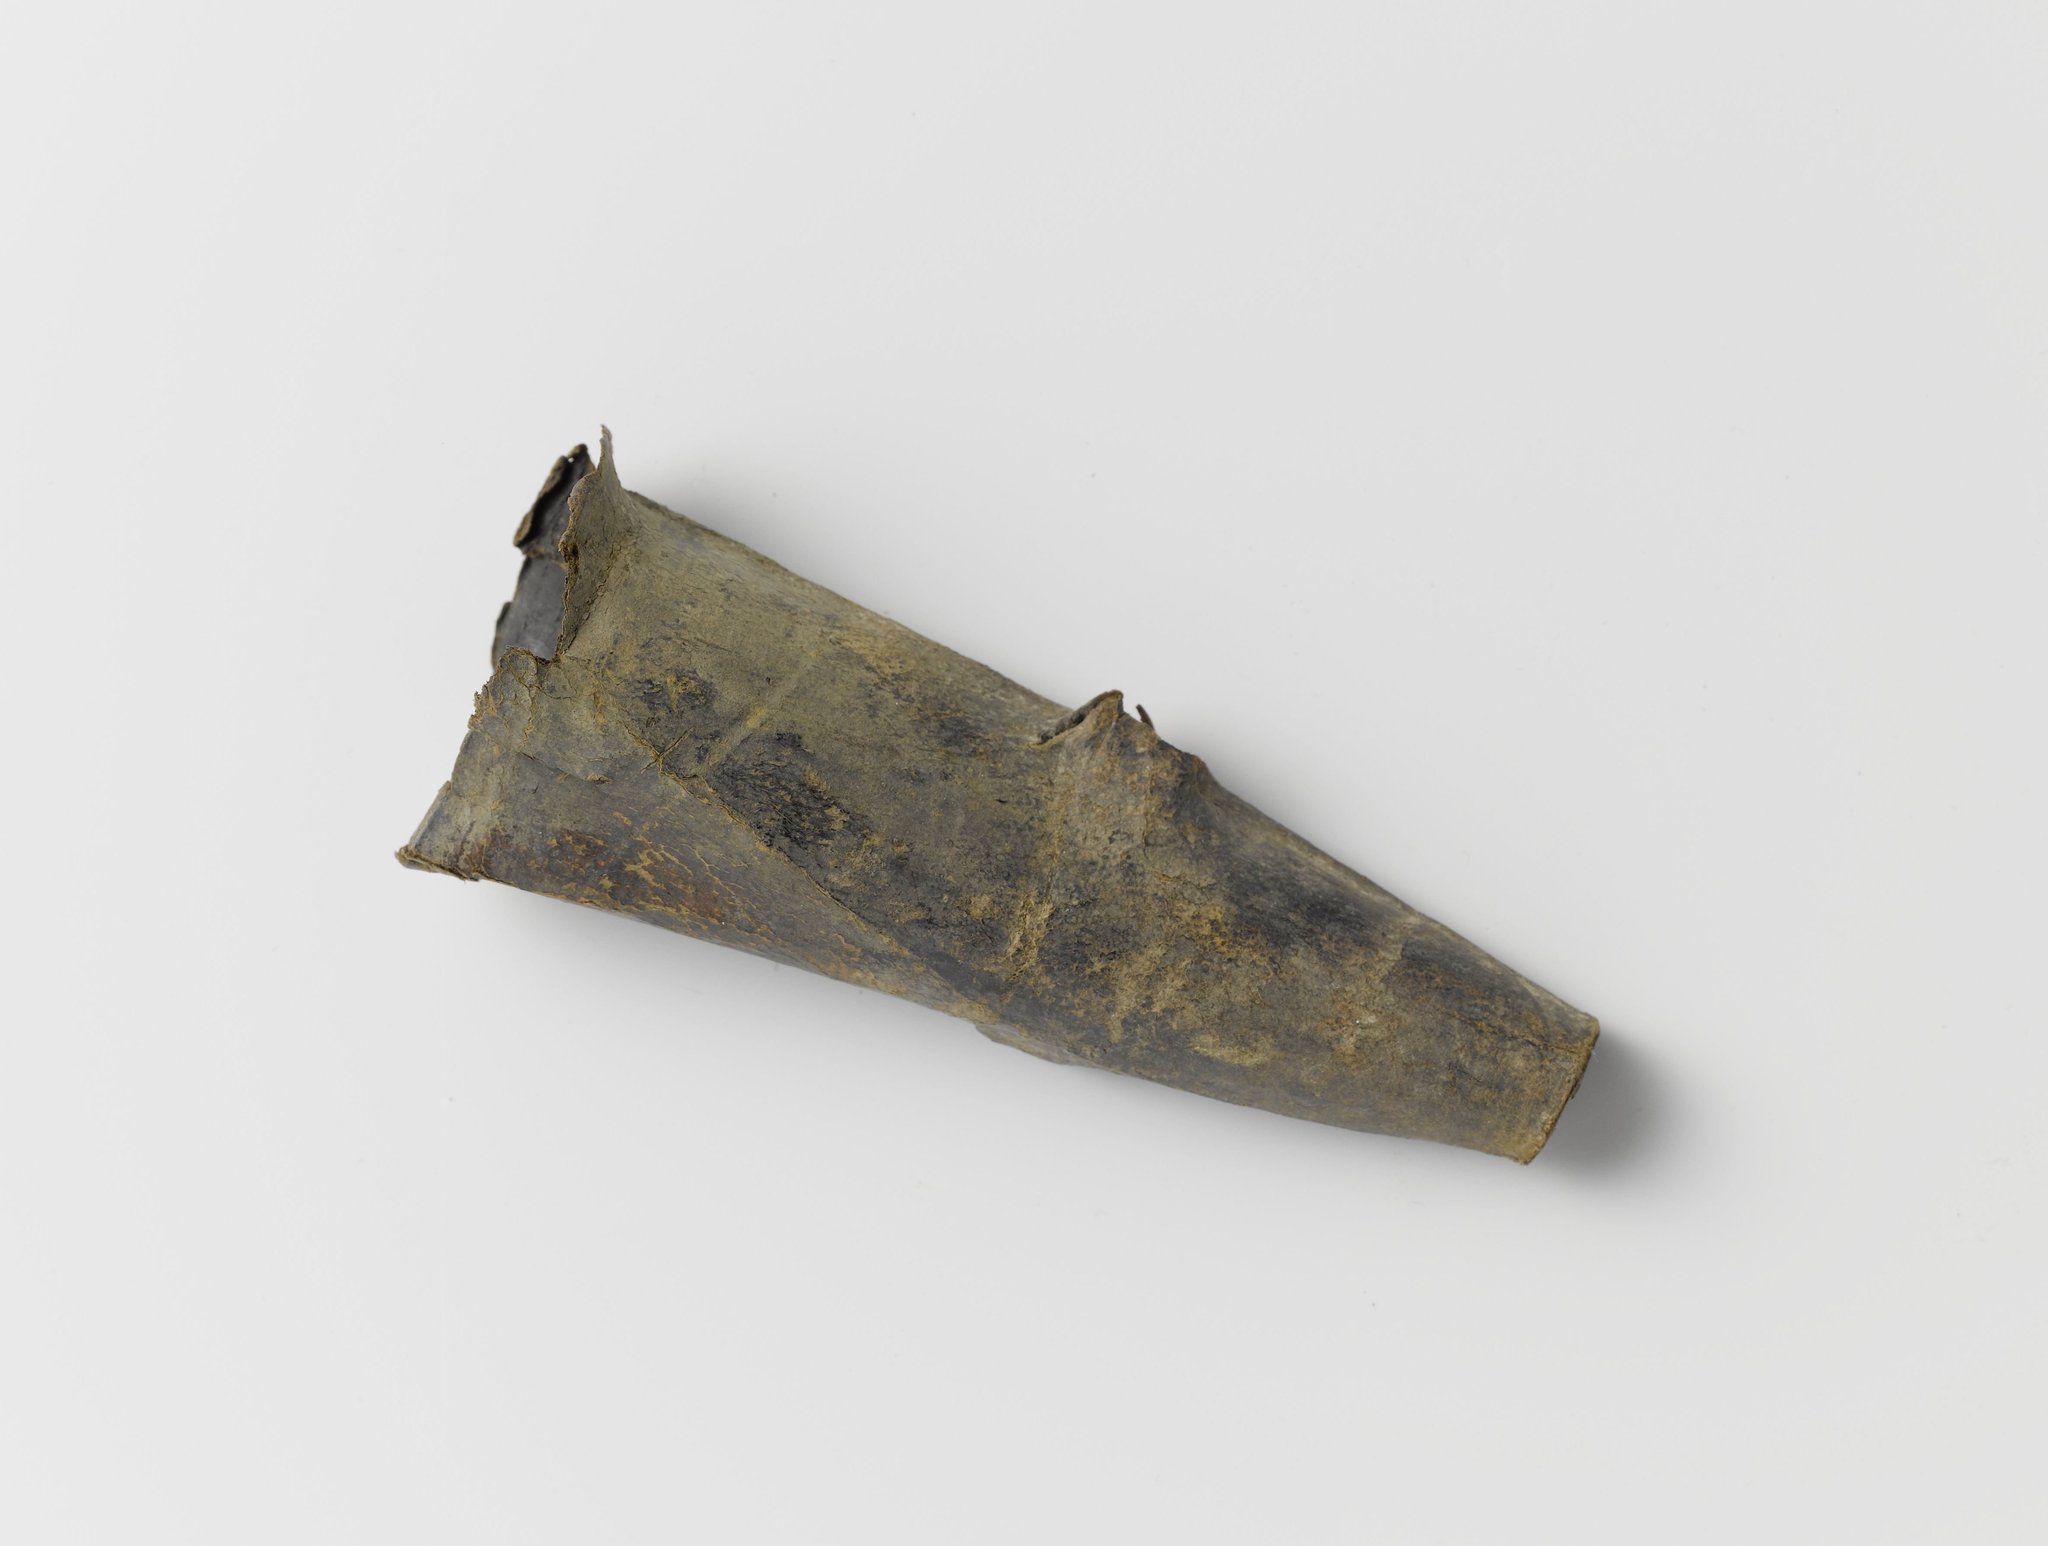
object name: kruitmaat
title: Musketmaat, leren huls met oortjes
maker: Anonymous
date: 1590-1596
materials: leather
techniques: cutting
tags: willem barendsz., amsterdam, jacob van heemskerck